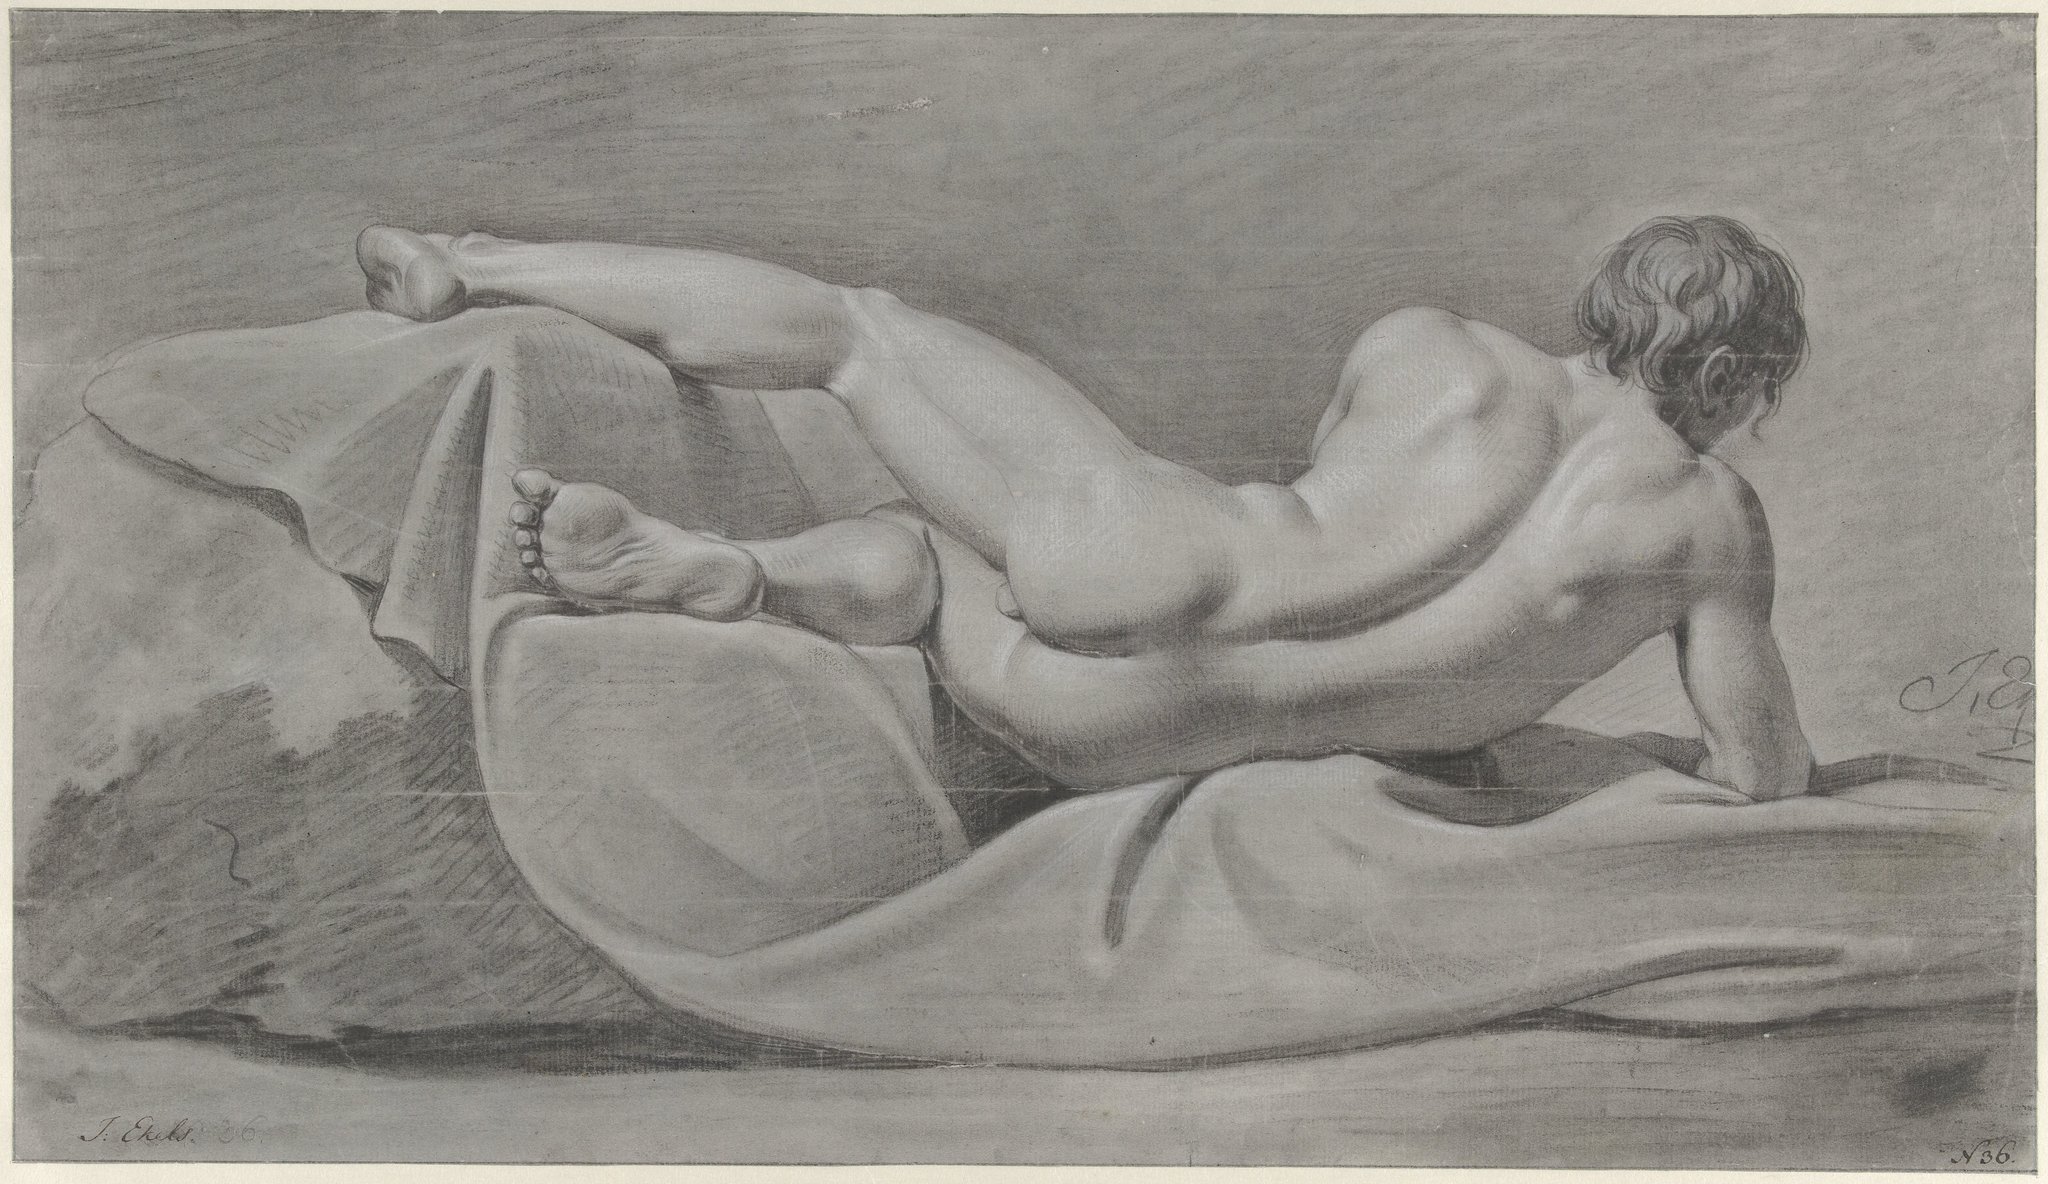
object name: drawing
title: Liggend mannelijk naakt, op de rug gezien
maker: jan ekels (ii)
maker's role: draughtsman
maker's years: 1759-1793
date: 1769-1793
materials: chalk, paper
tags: lying figure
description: Liggend mannelijk naakt, op de rug gezien. Nr. 36.